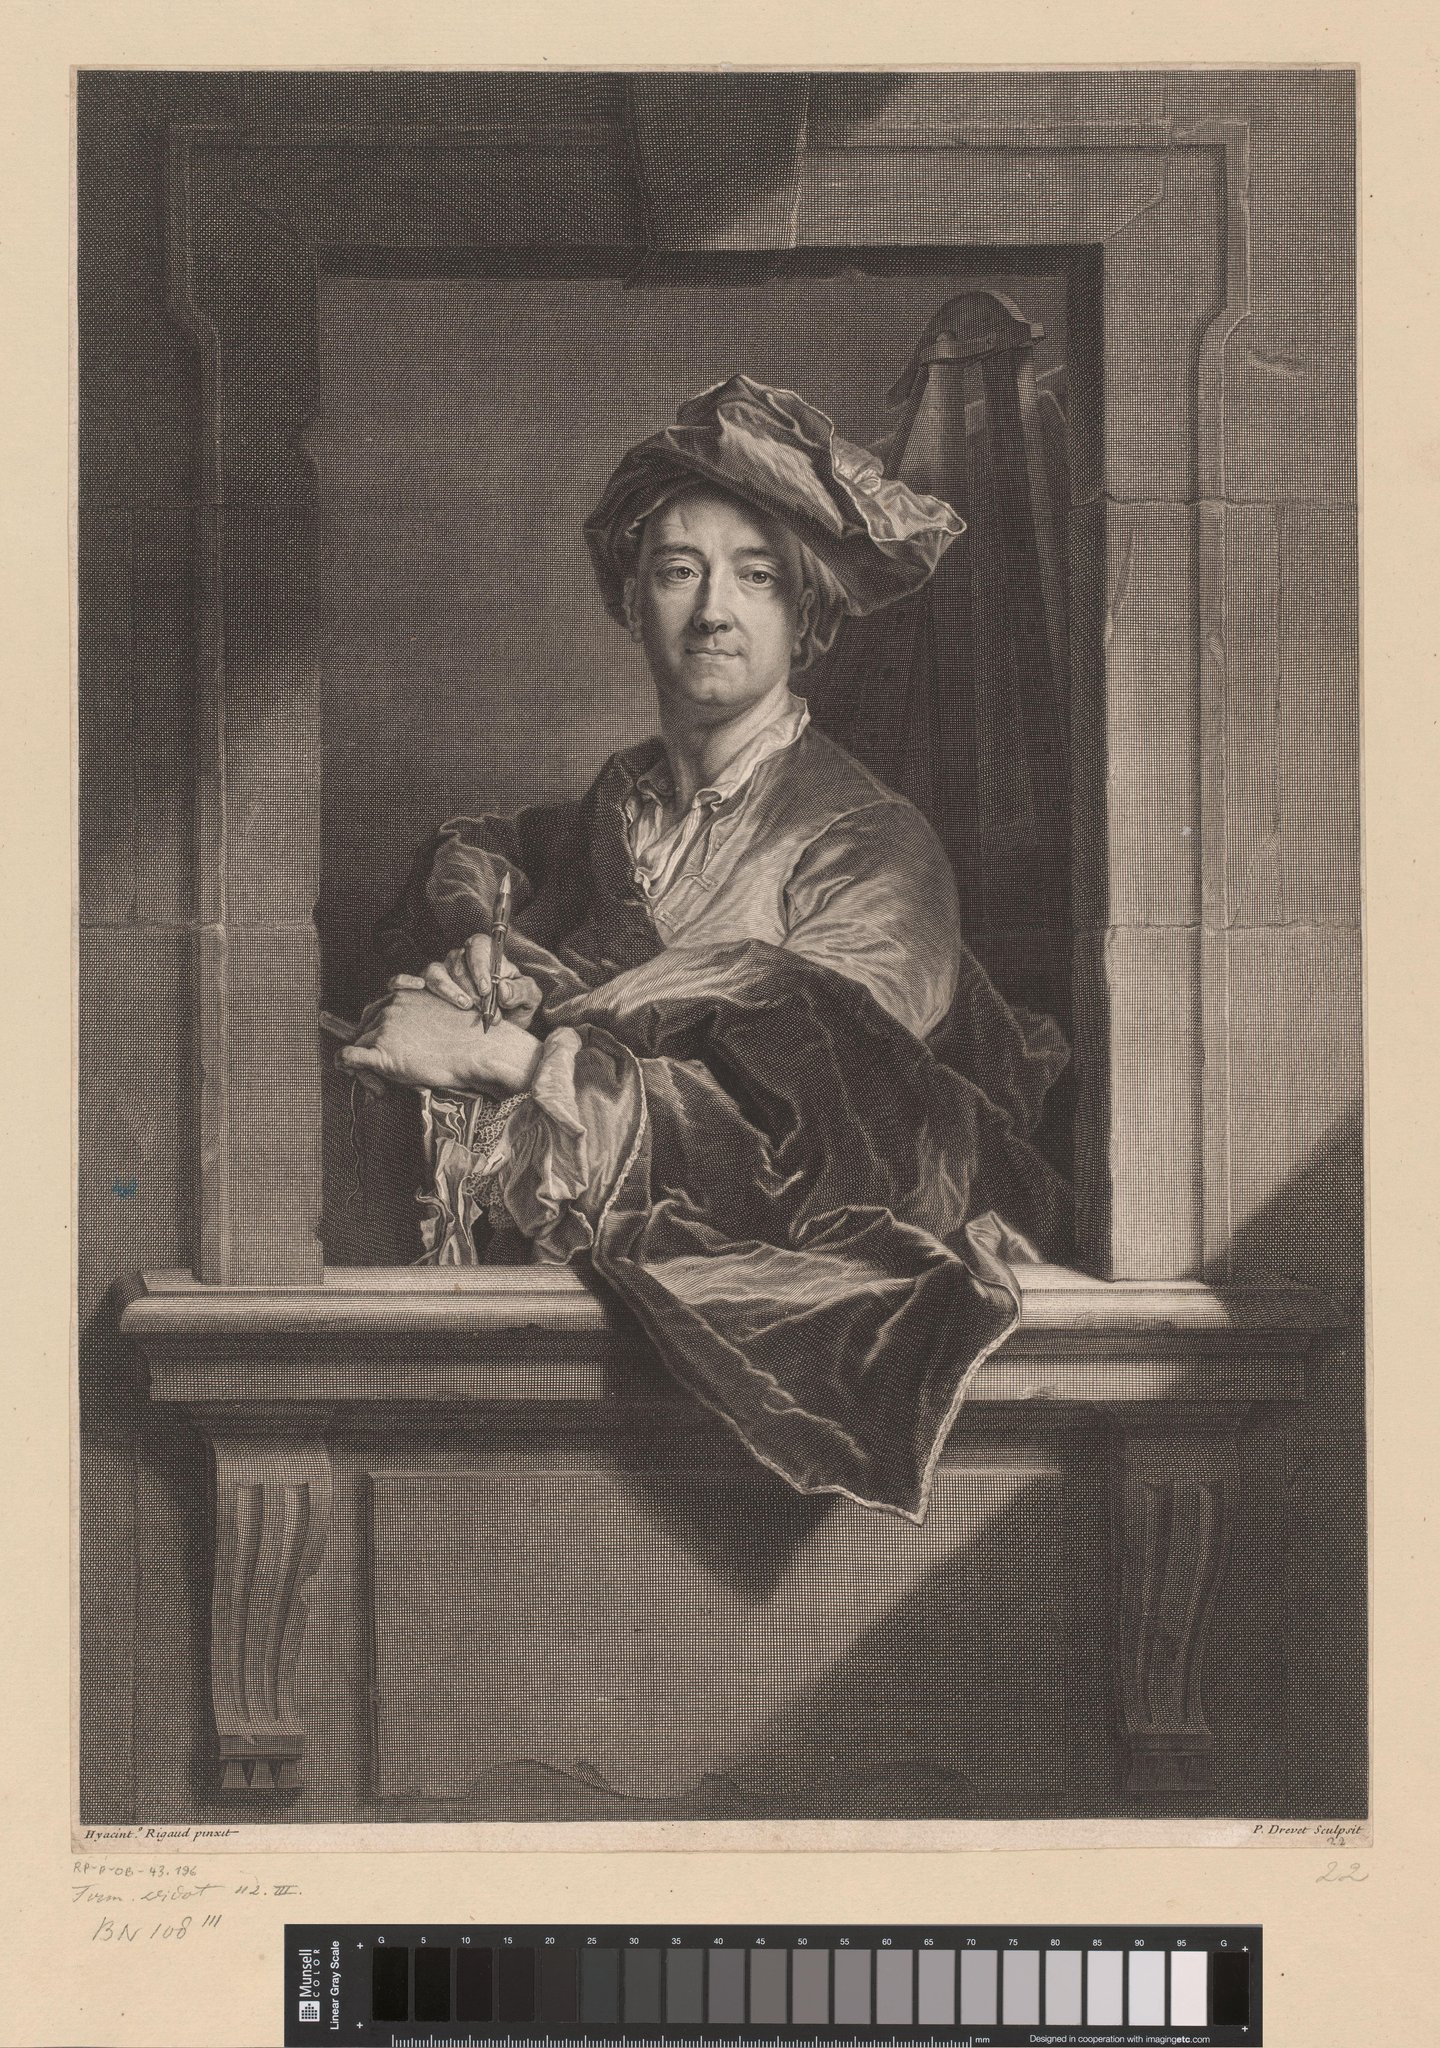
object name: print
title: Portret van Hyacinthe Rigaud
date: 1701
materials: paper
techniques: engraving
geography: france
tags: paris, draughtsman, hyacinthe rigaud, portrait, self-portrait of painter, human figure at (open) window, seen from outside - aa - feigned window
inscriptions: collector's mark: Lugt 240